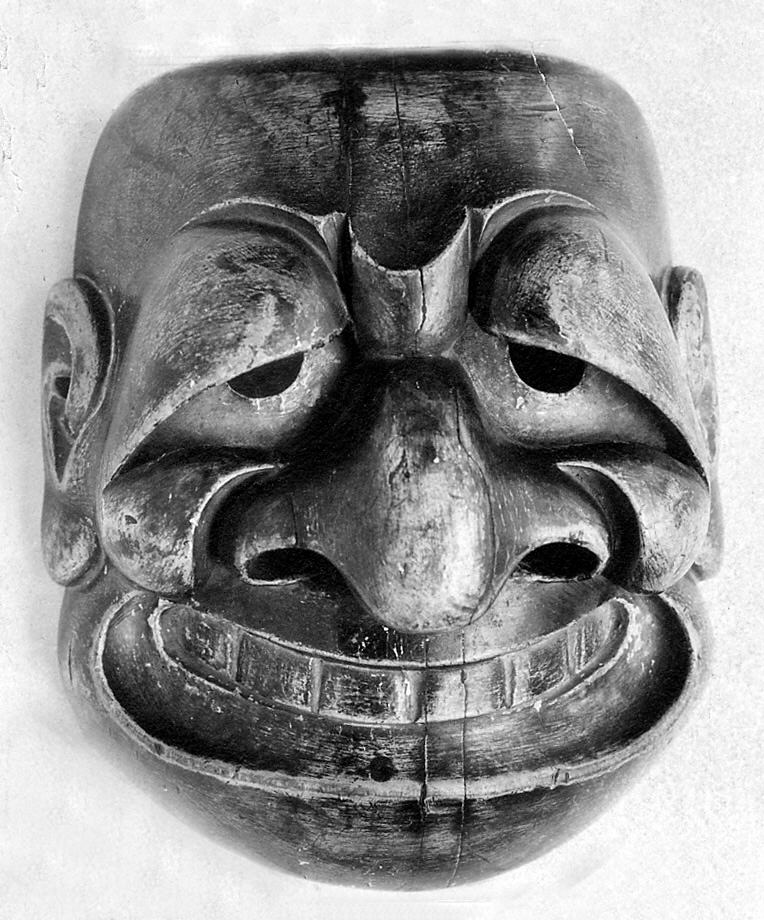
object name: noh mask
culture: japanese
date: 1701-1800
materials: wood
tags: masks